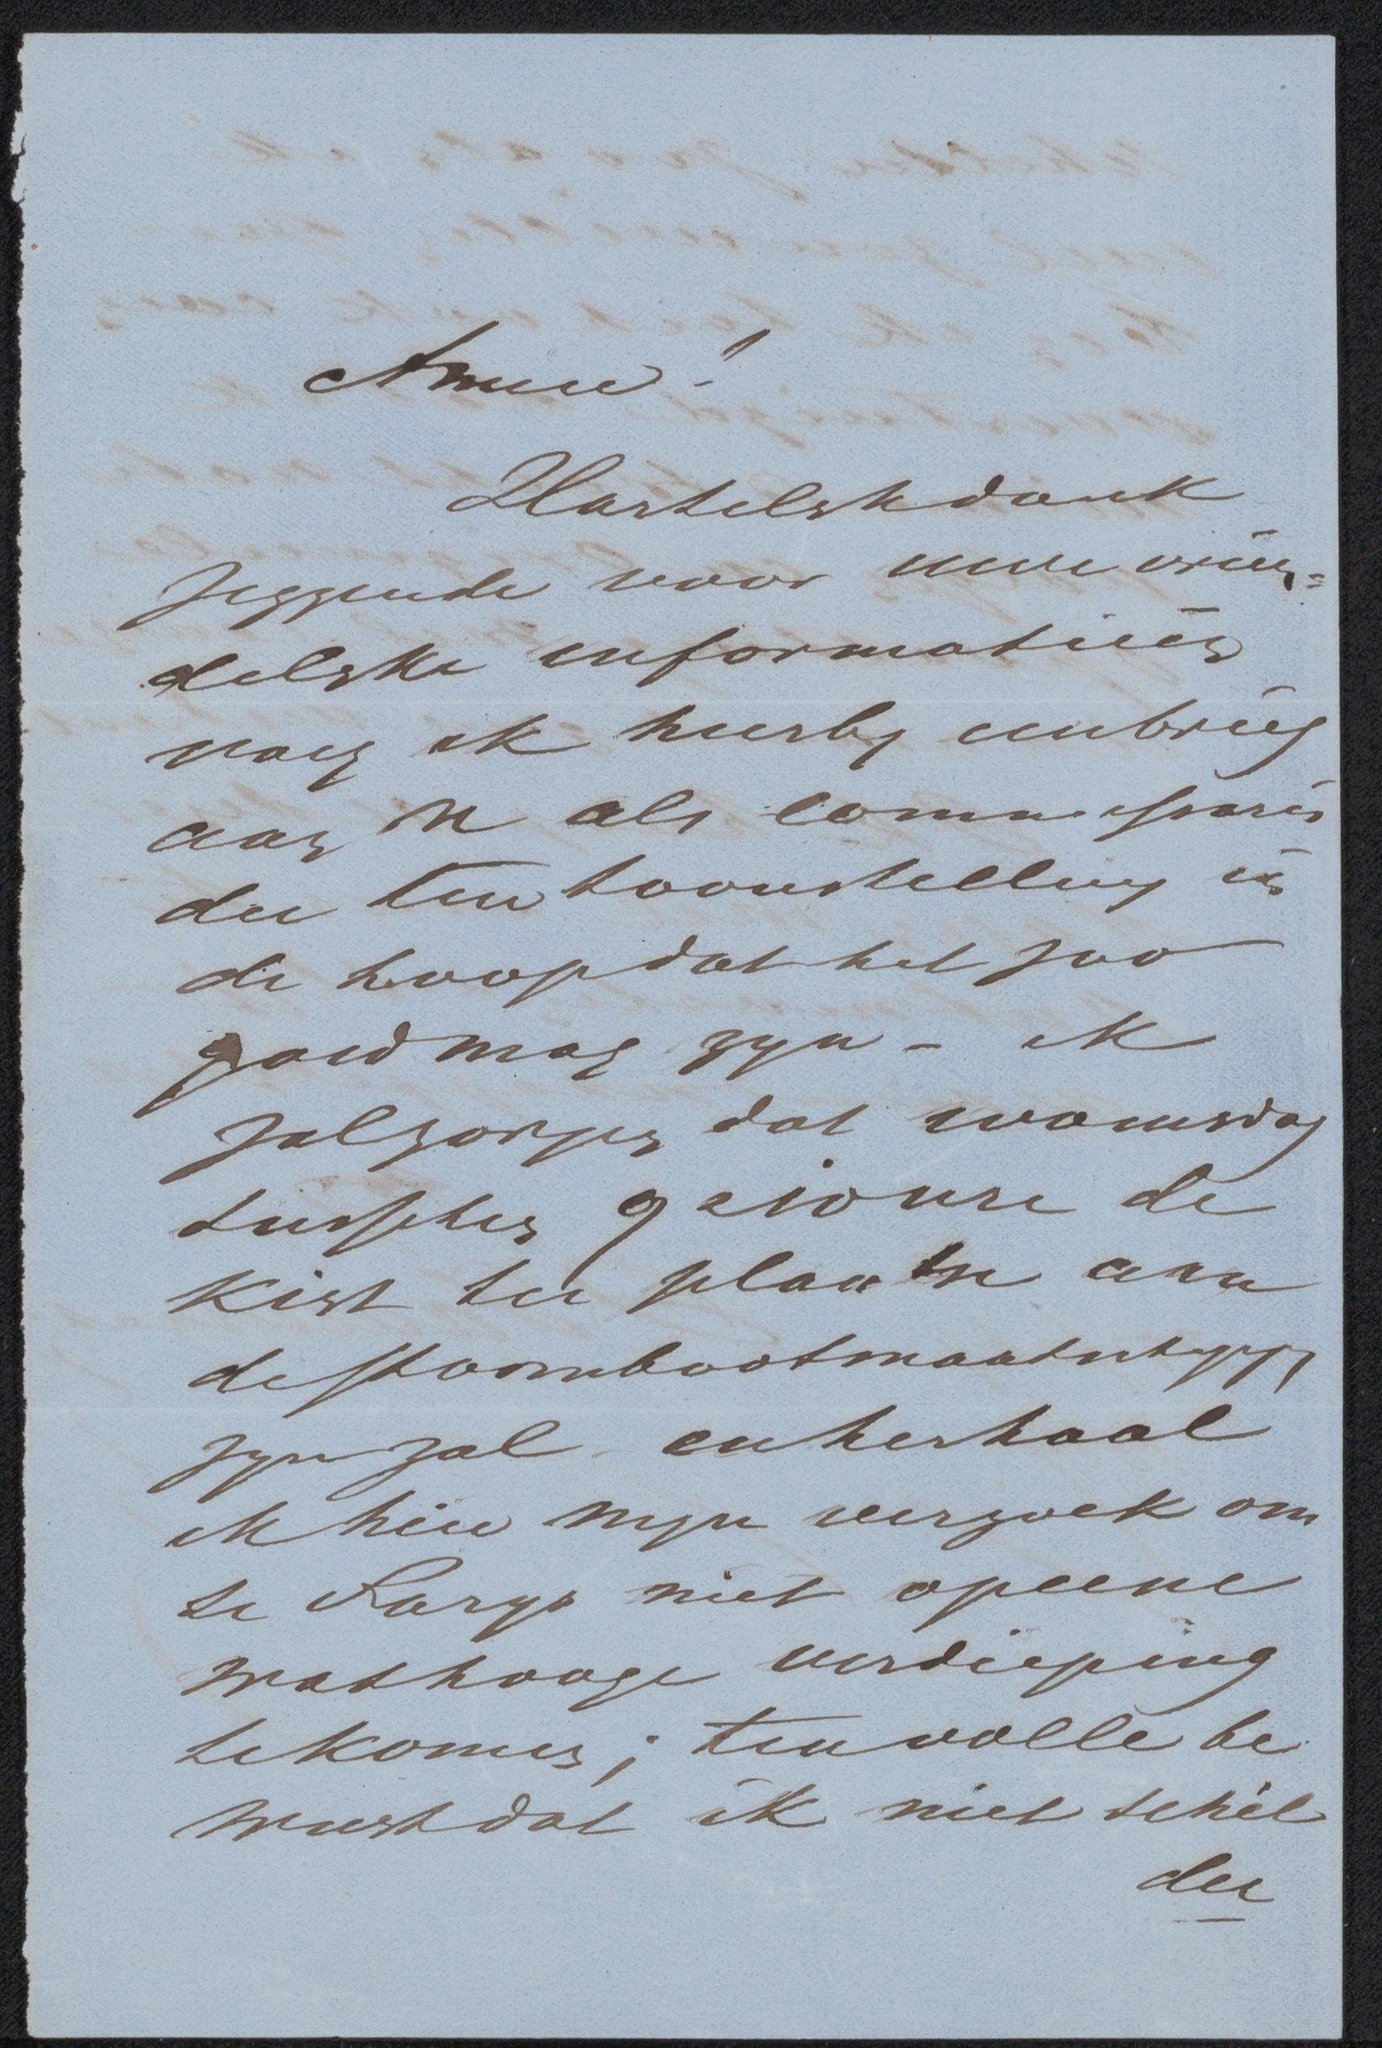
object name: letter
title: Brief aan Ary Johannes Lamme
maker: johannes tavenraat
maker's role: draughtsman, painter, print maker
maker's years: 1809-1881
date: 1867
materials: ink, paper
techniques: pen, writing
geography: rotterdam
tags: ary johannes lamme, painting (including book-illumination, miniature-painting), exhibition ~ art, paris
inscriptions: collector's mark: Lugt 2228